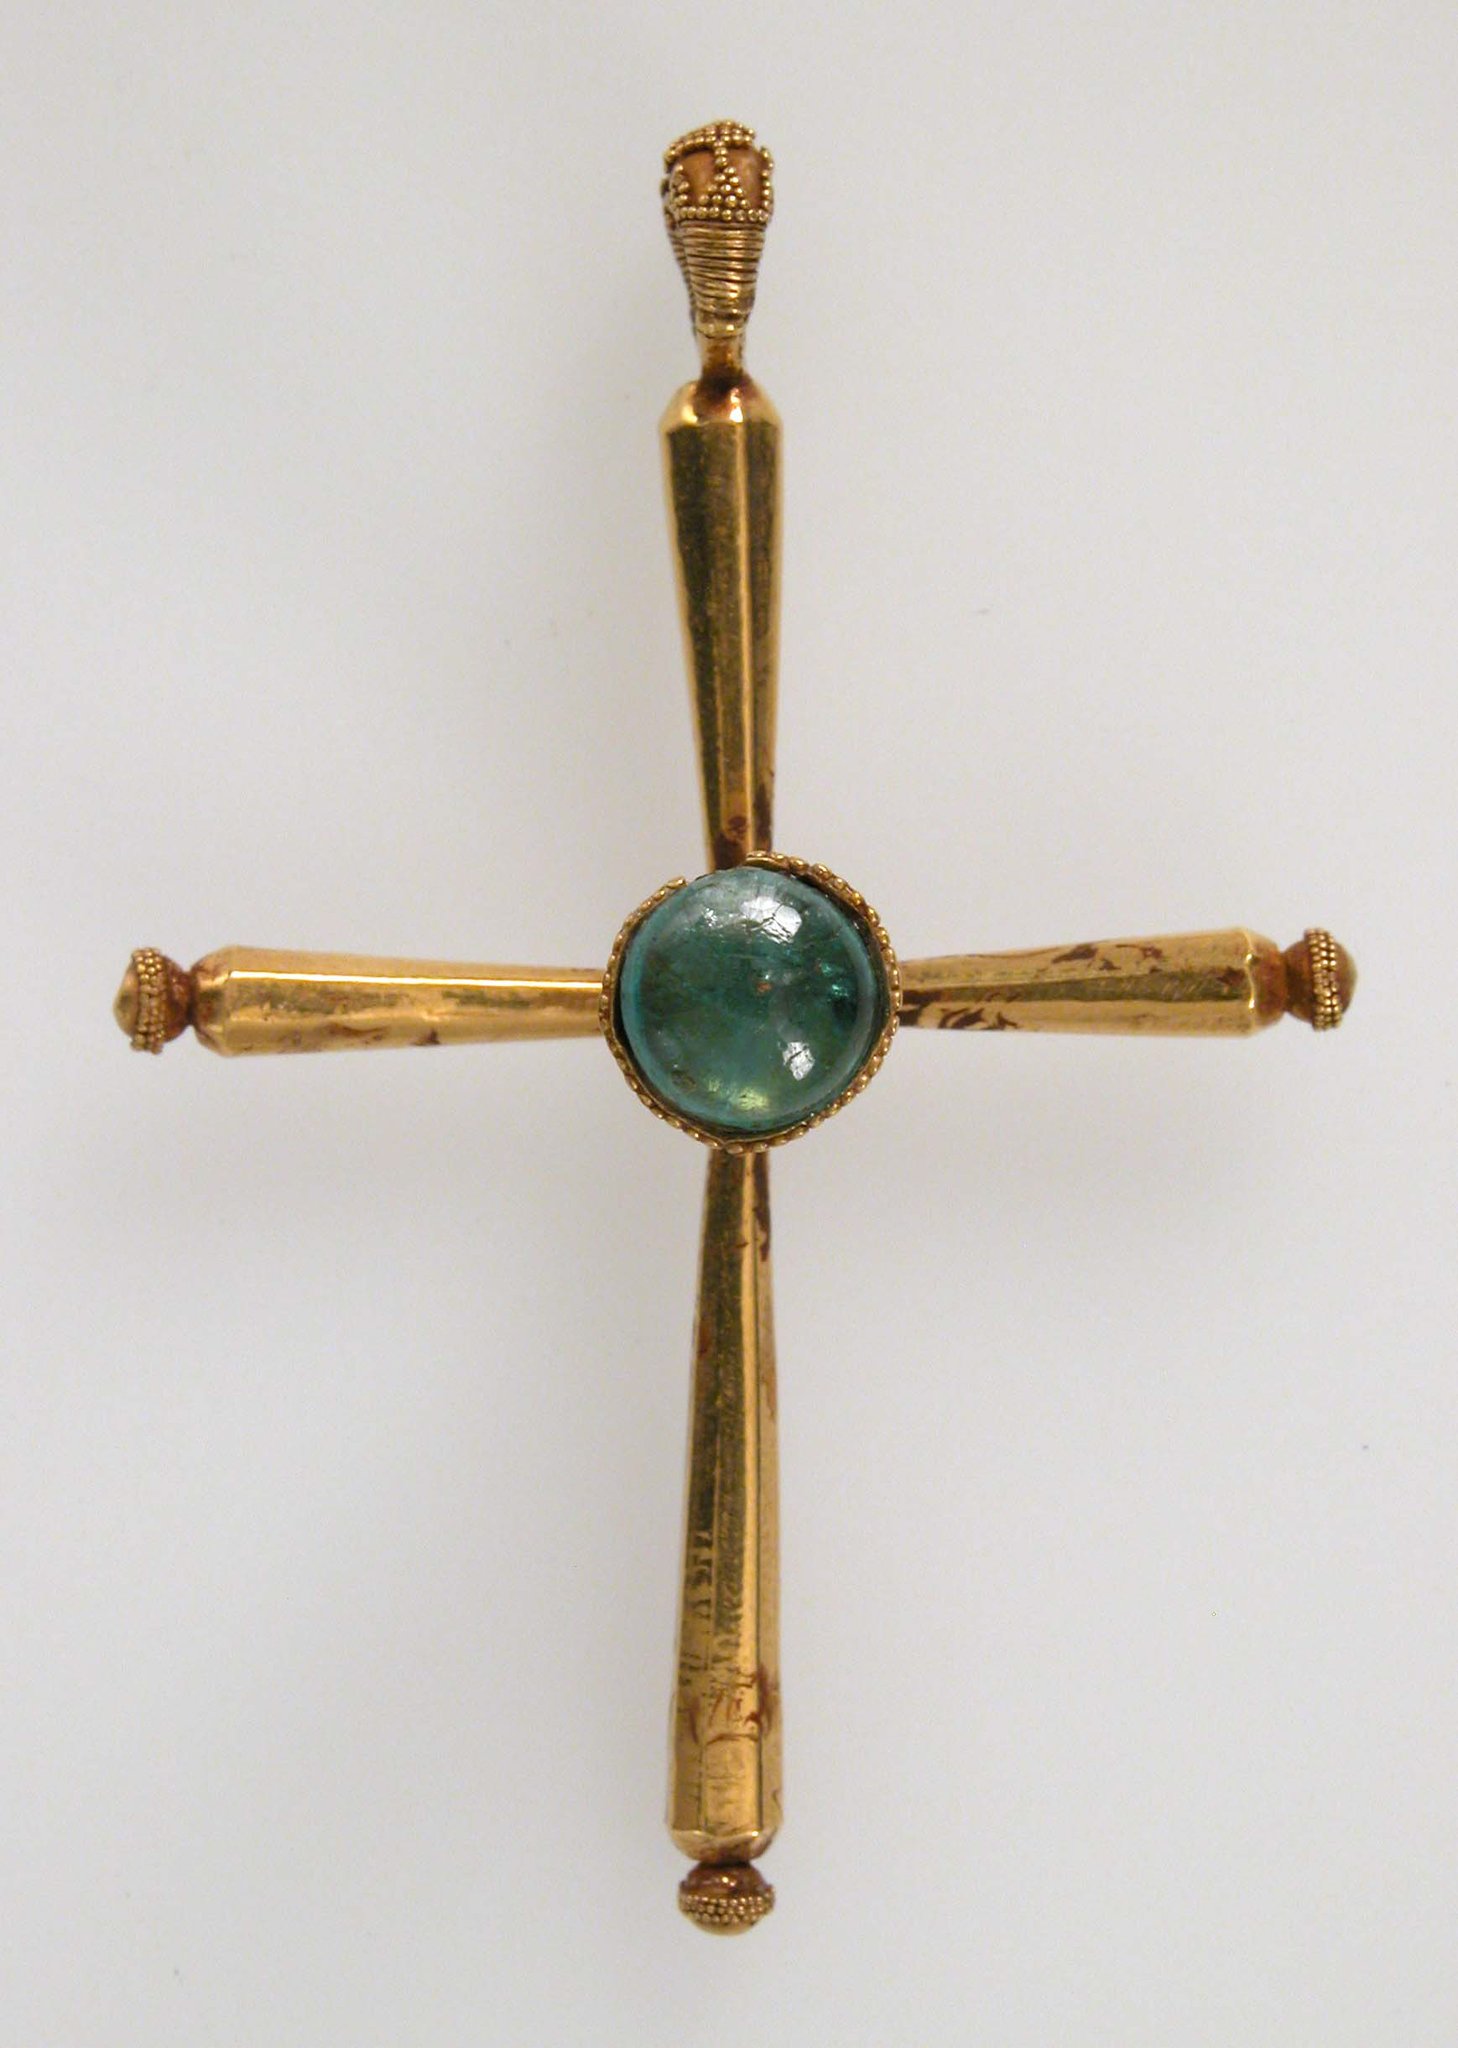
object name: pendant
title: Pendant in the form of a Latin Cross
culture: byzantine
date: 1867-2000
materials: gemstone, gold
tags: cross